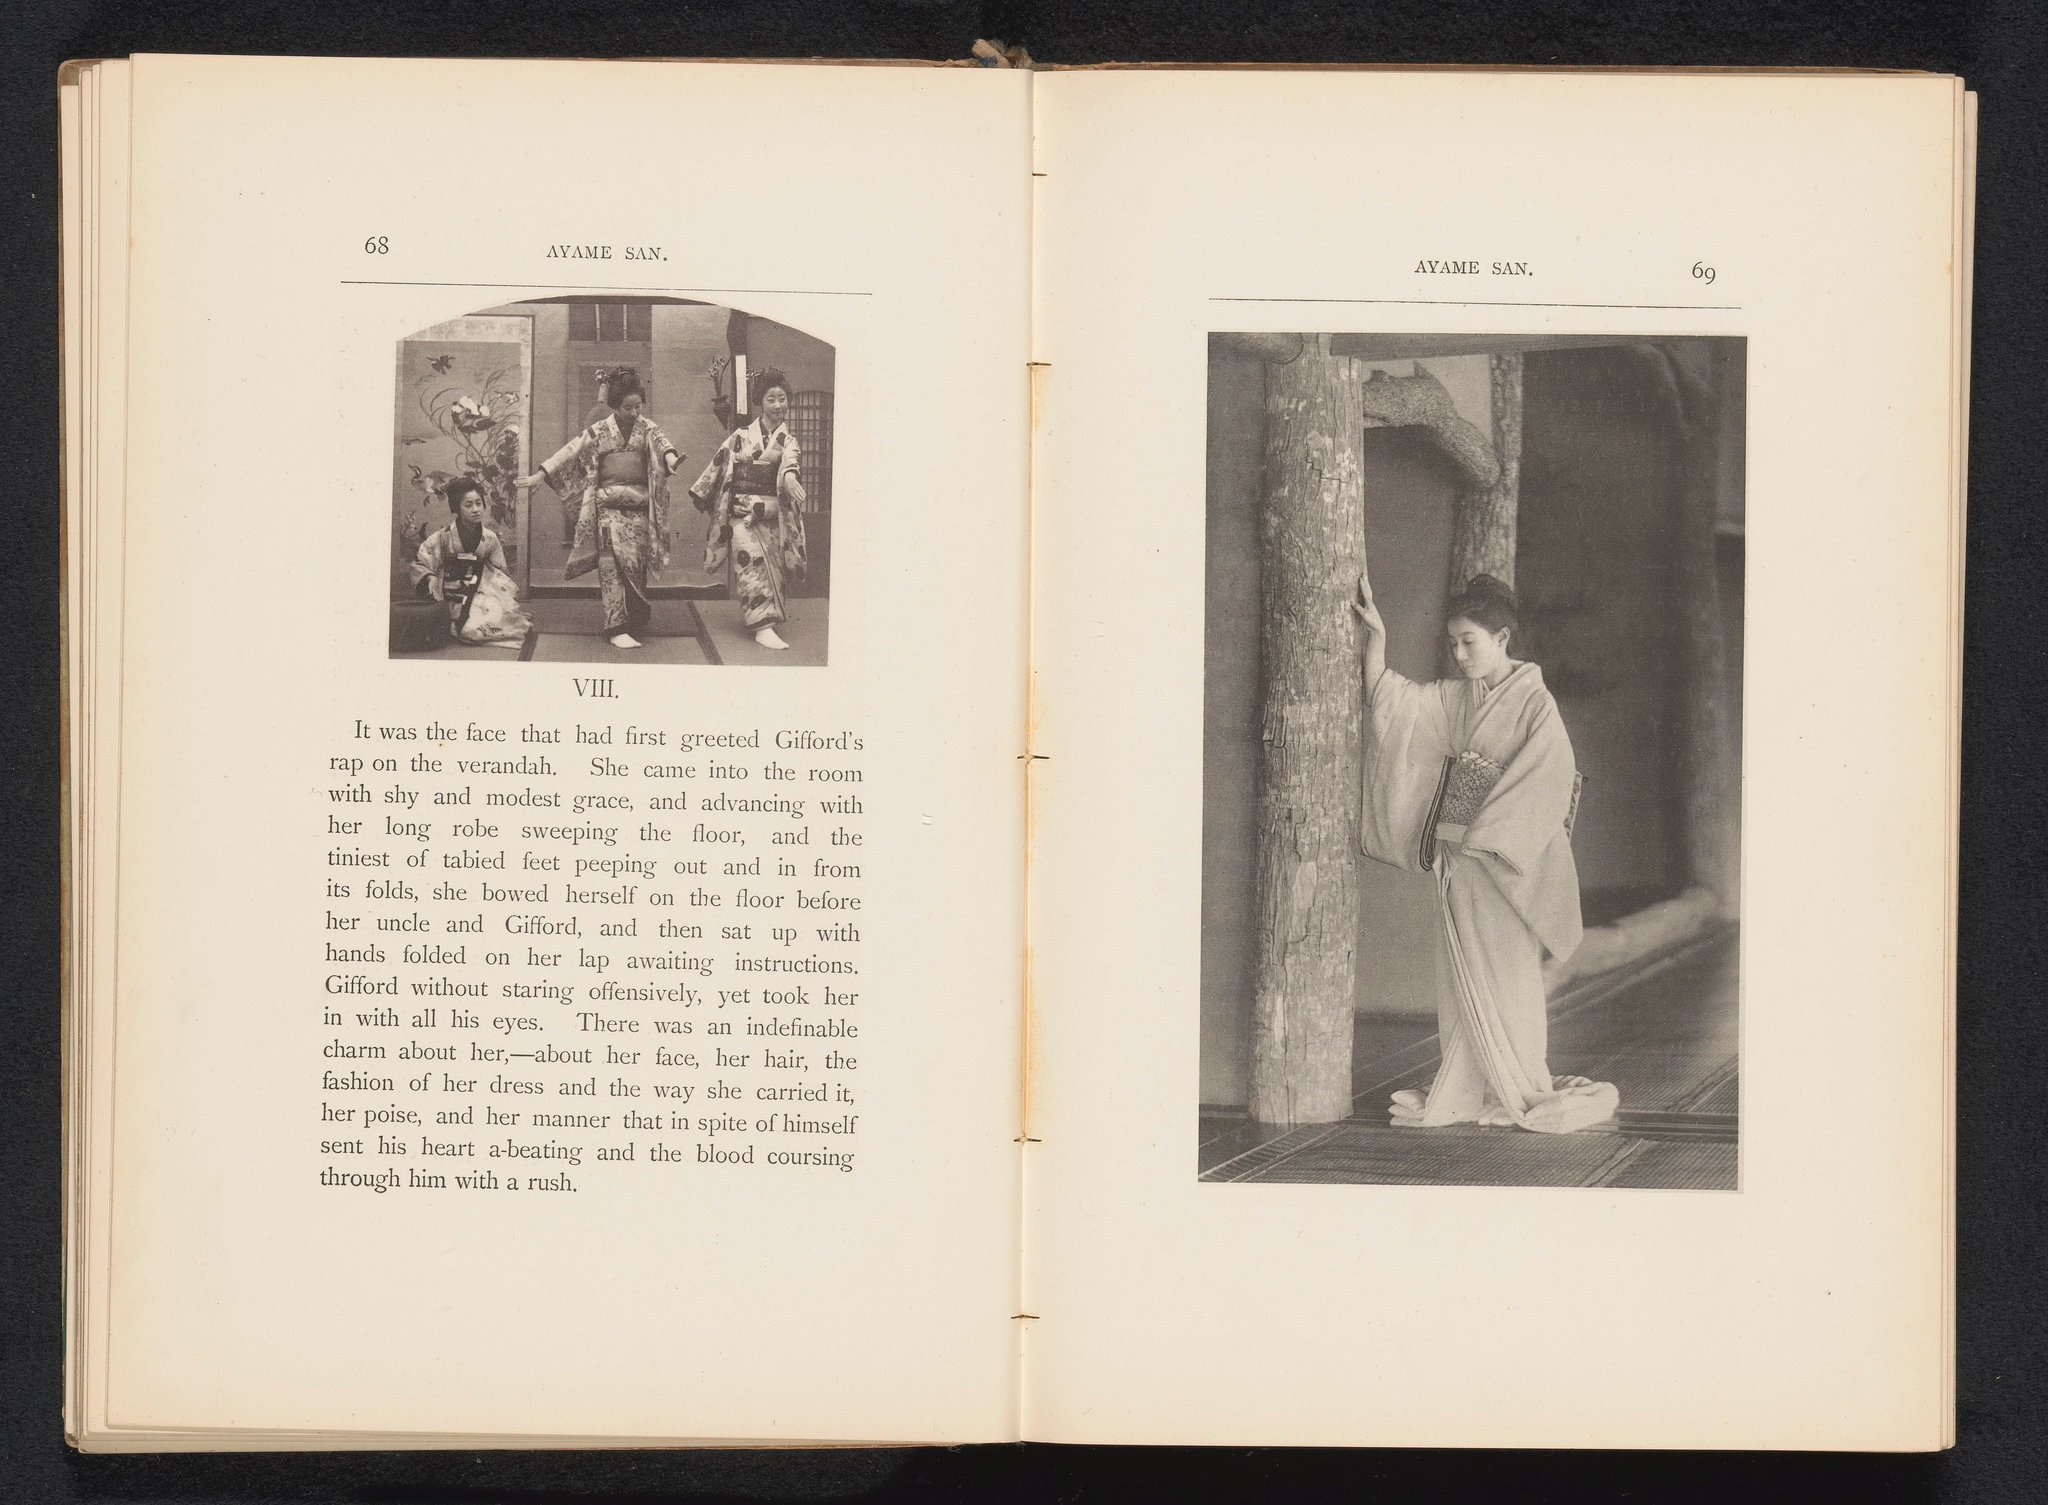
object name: page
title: Vrouw naast een houten pilaar in een interieur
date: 1882-1892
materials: paper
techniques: photograph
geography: japan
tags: adult woman, interior ~ representation of a building